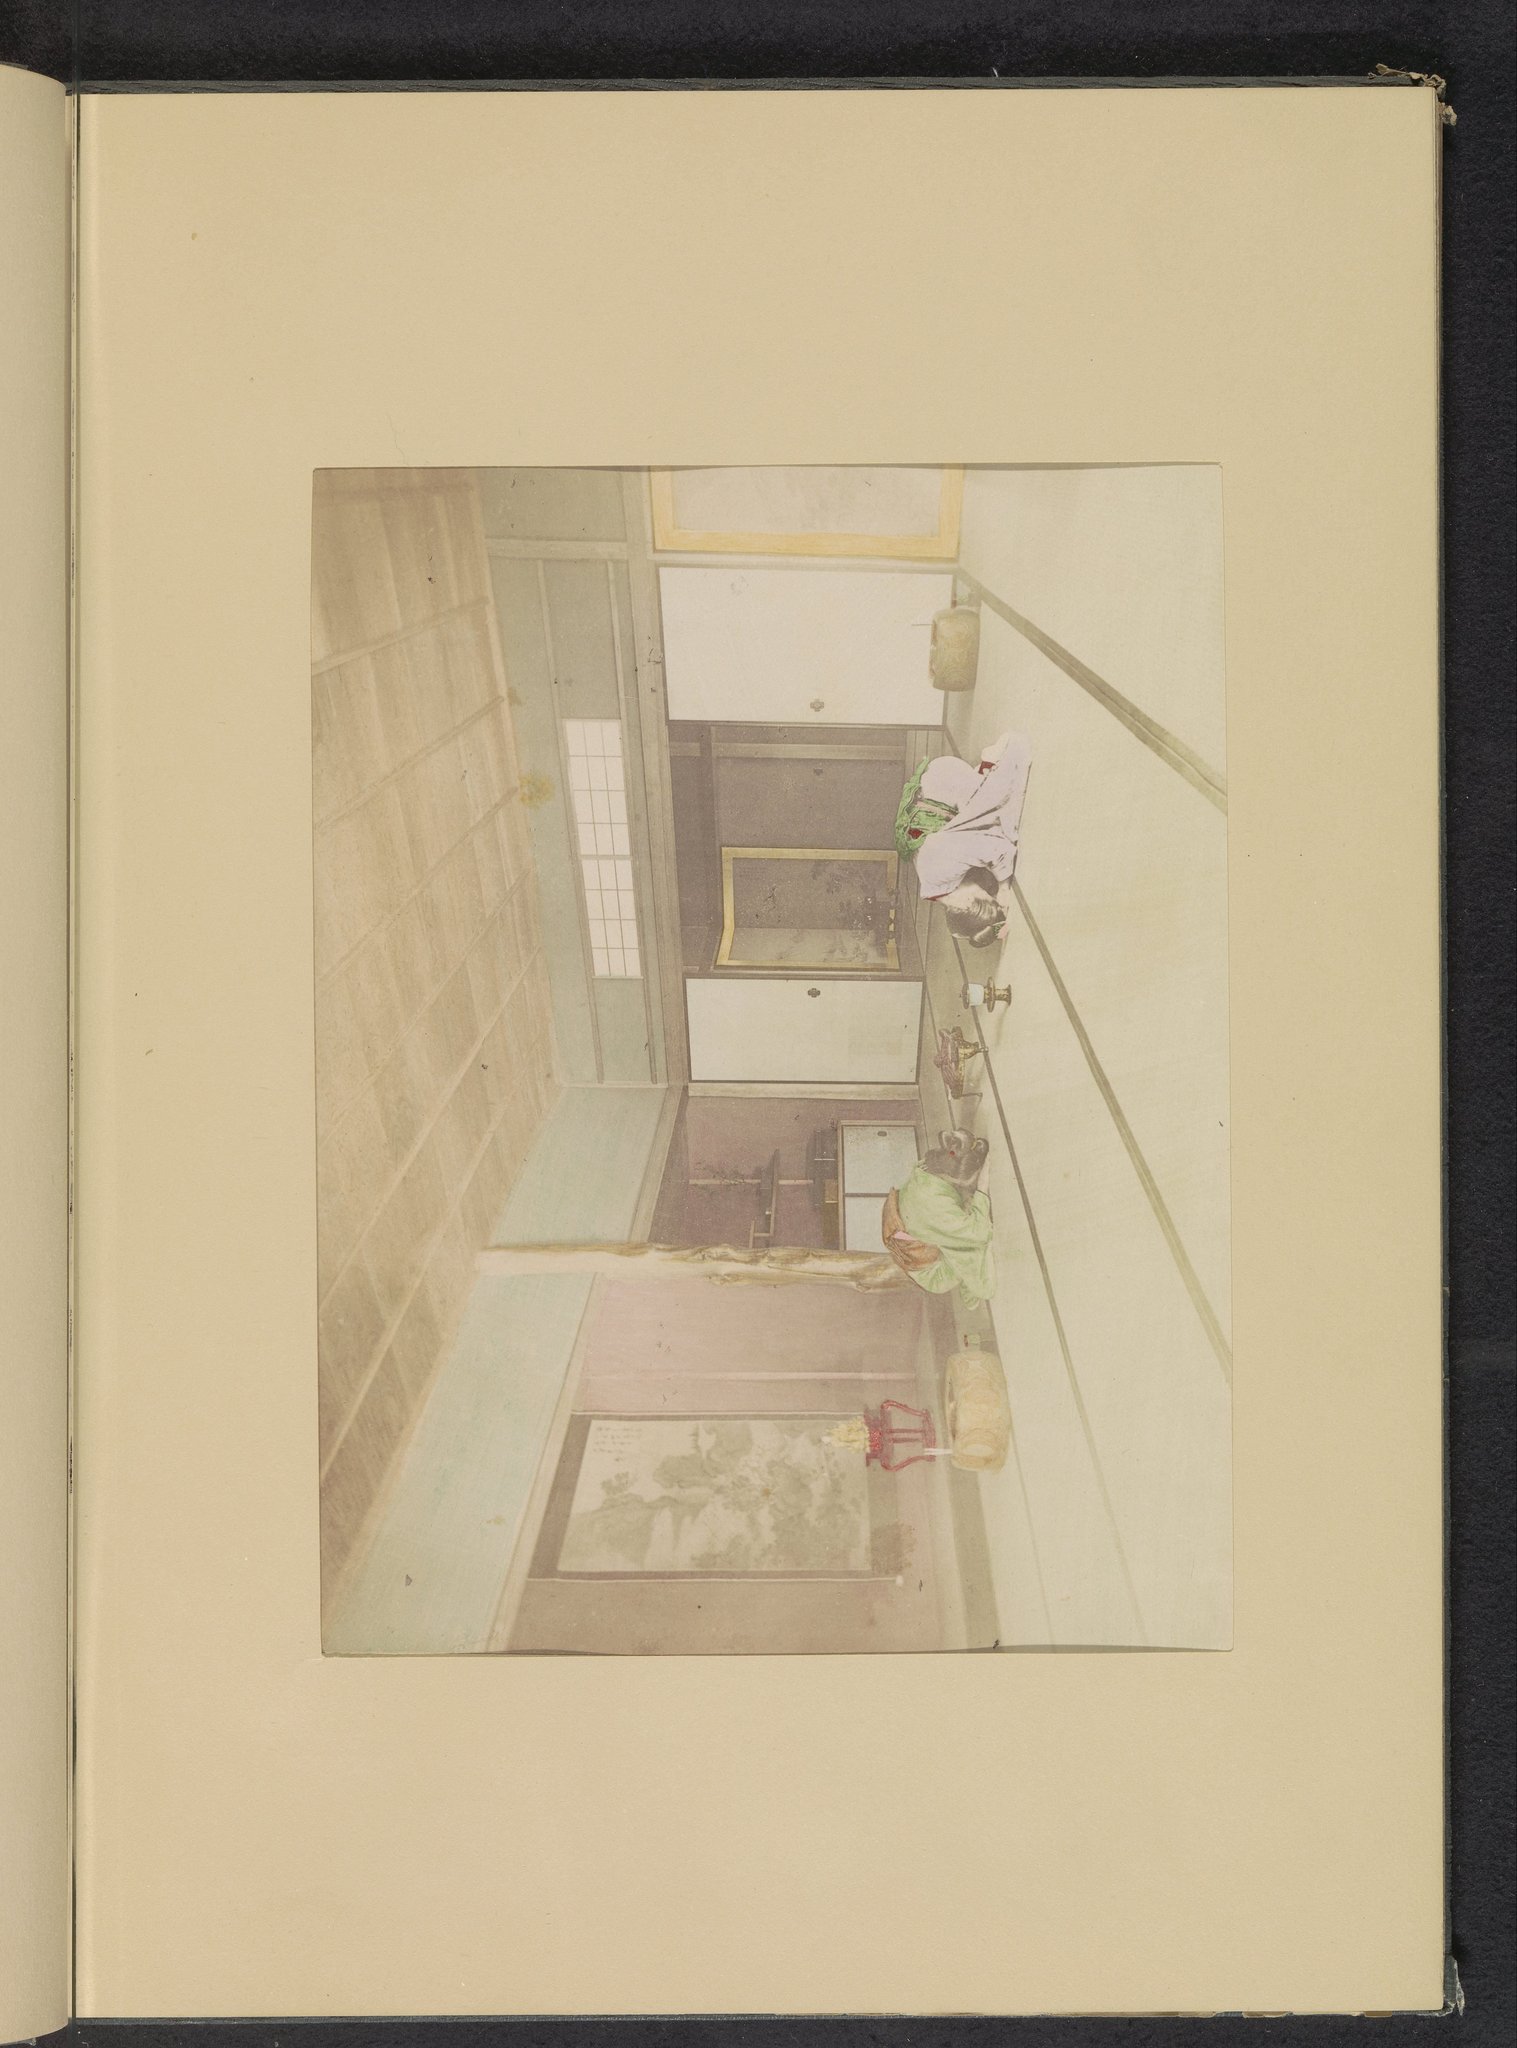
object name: photograph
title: Twee vrouwen begroeten elkaar met een buiging in een interieur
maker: Anonymous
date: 1887-1897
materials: photographic support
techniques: albumen print, hand coloring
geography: japan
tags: head bent forward; bowing - aa - female human figure, kneeling figure, interior ~ representation of a building